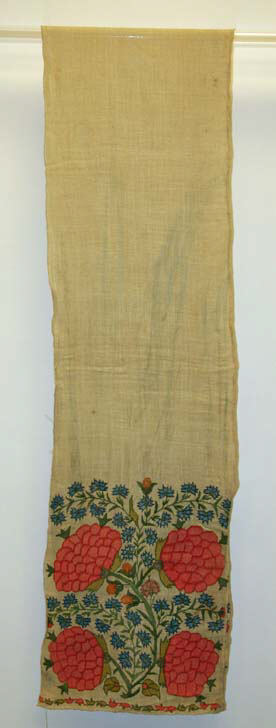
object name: textile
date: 1801-1900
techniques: embroidery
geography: turkey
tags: flowers